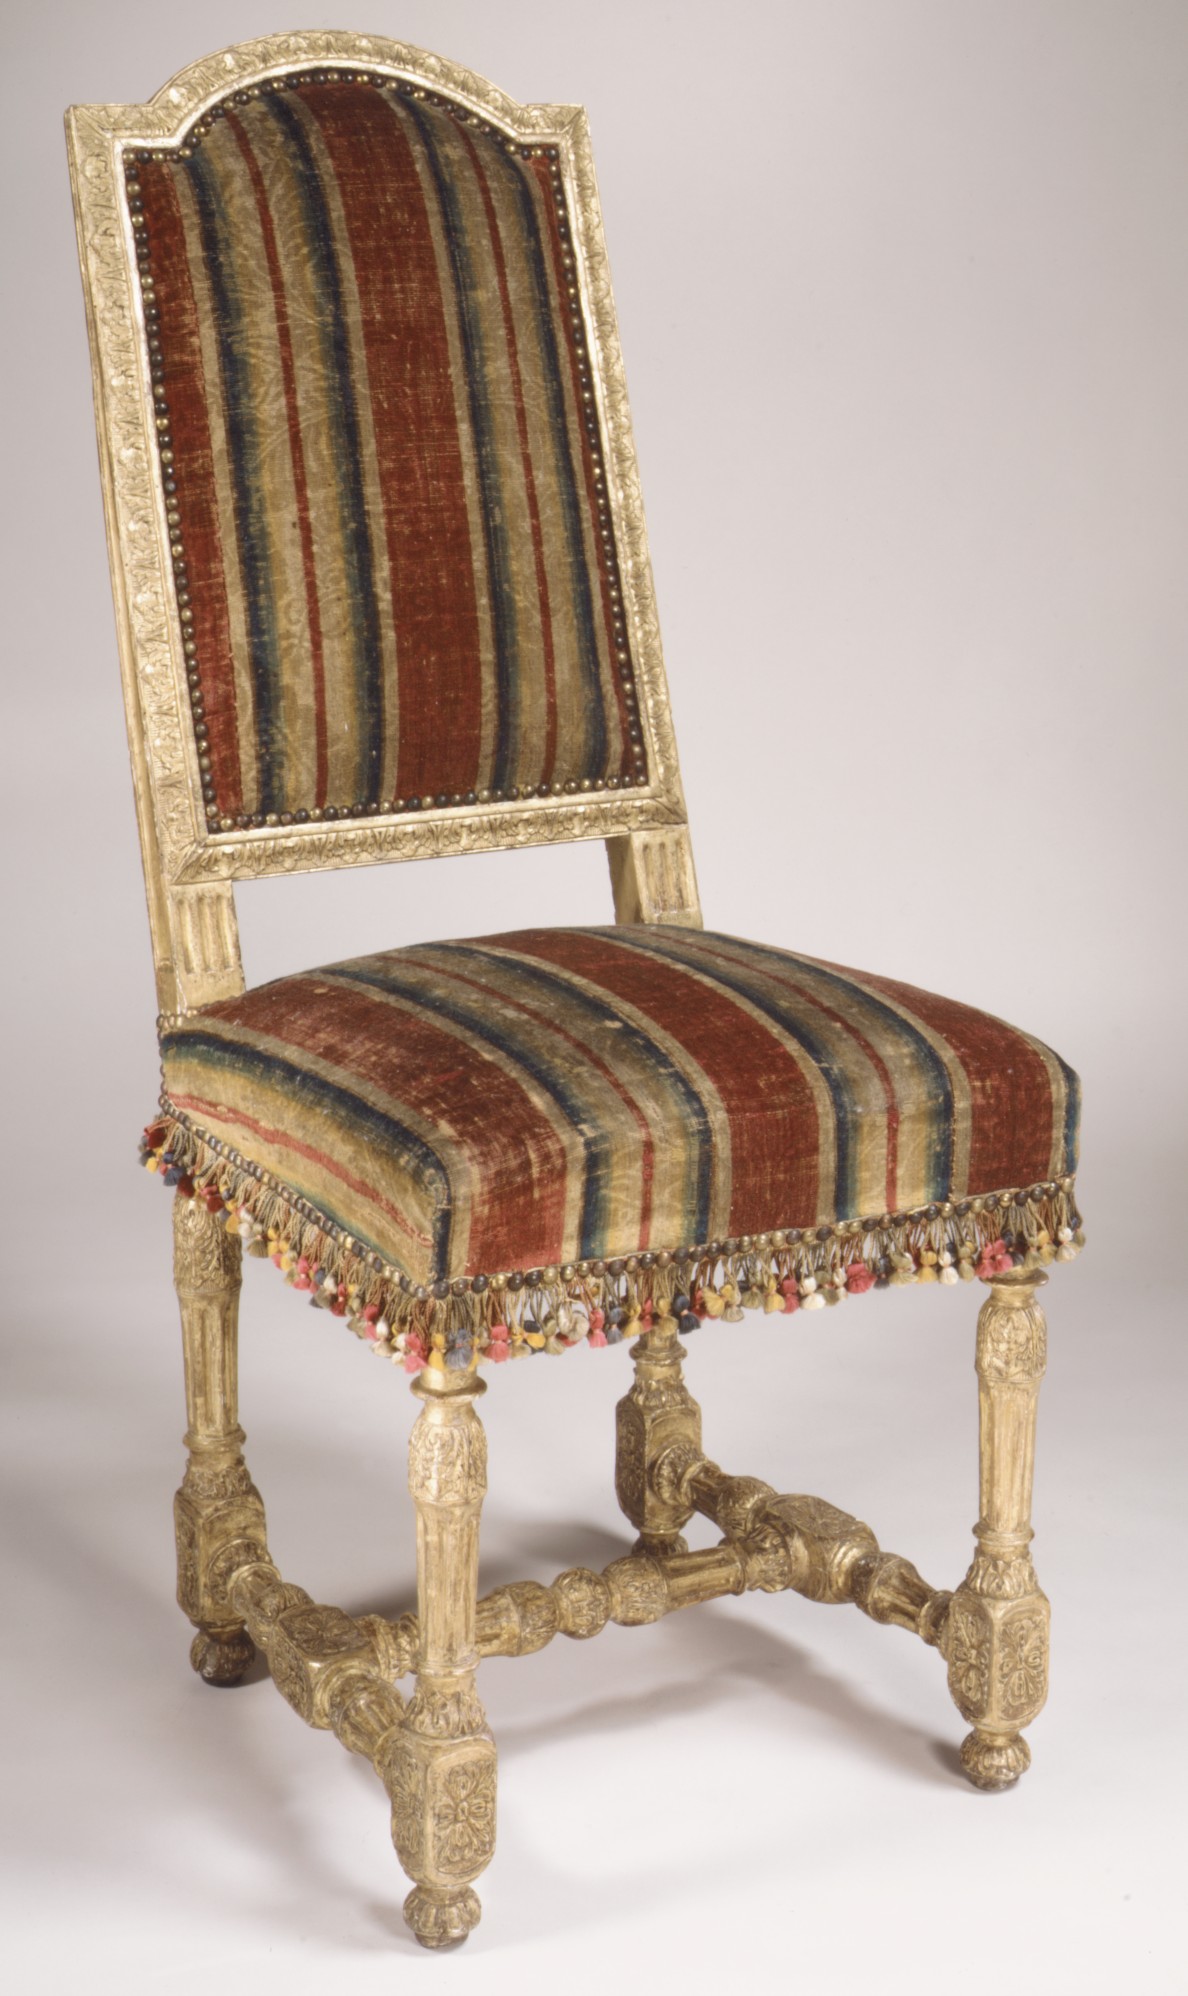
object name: side chair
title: Side chair (one of a pair)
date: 1690-1700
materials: wood, velvet, wool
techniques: carving, gilding